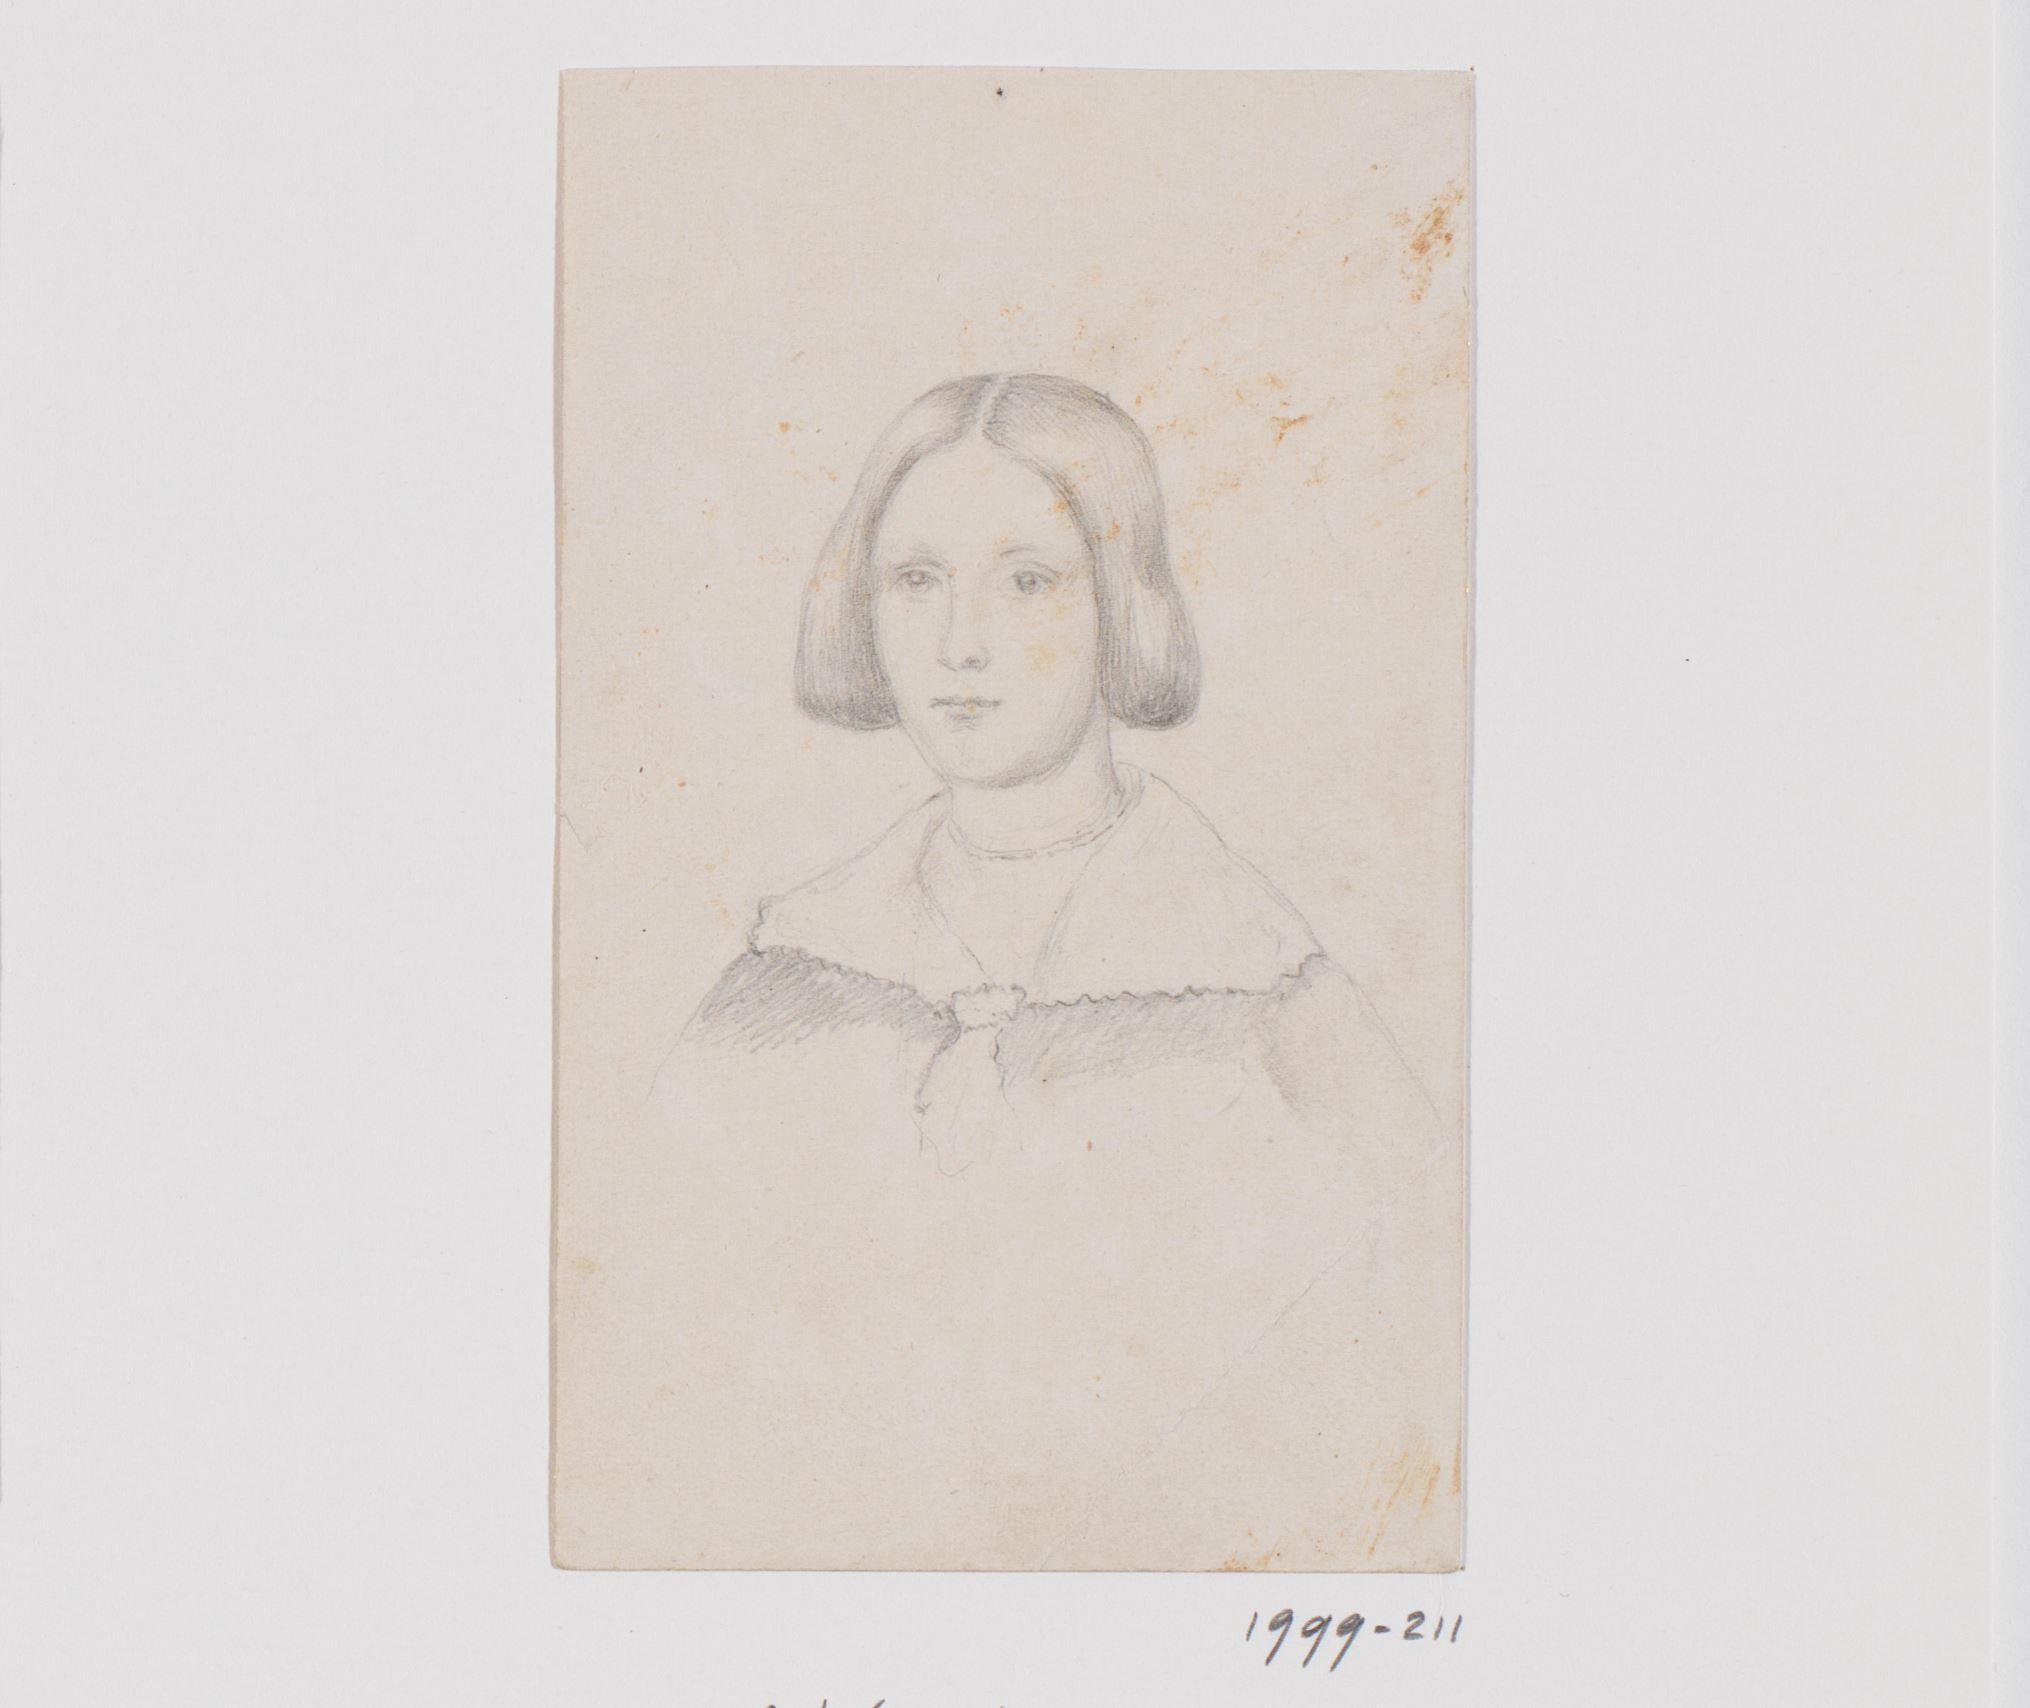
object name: drawing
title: Portret van een onbekend Europees meisje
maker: adrianus johannes bik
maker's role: draughtsman, print maker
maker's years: 1790-1872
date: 1860-1872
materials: paper, pencil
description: artikel over deze collectie in Bulletin van het Rijksmuseum 49 [2001], nr. 4, pp.343 e.v.